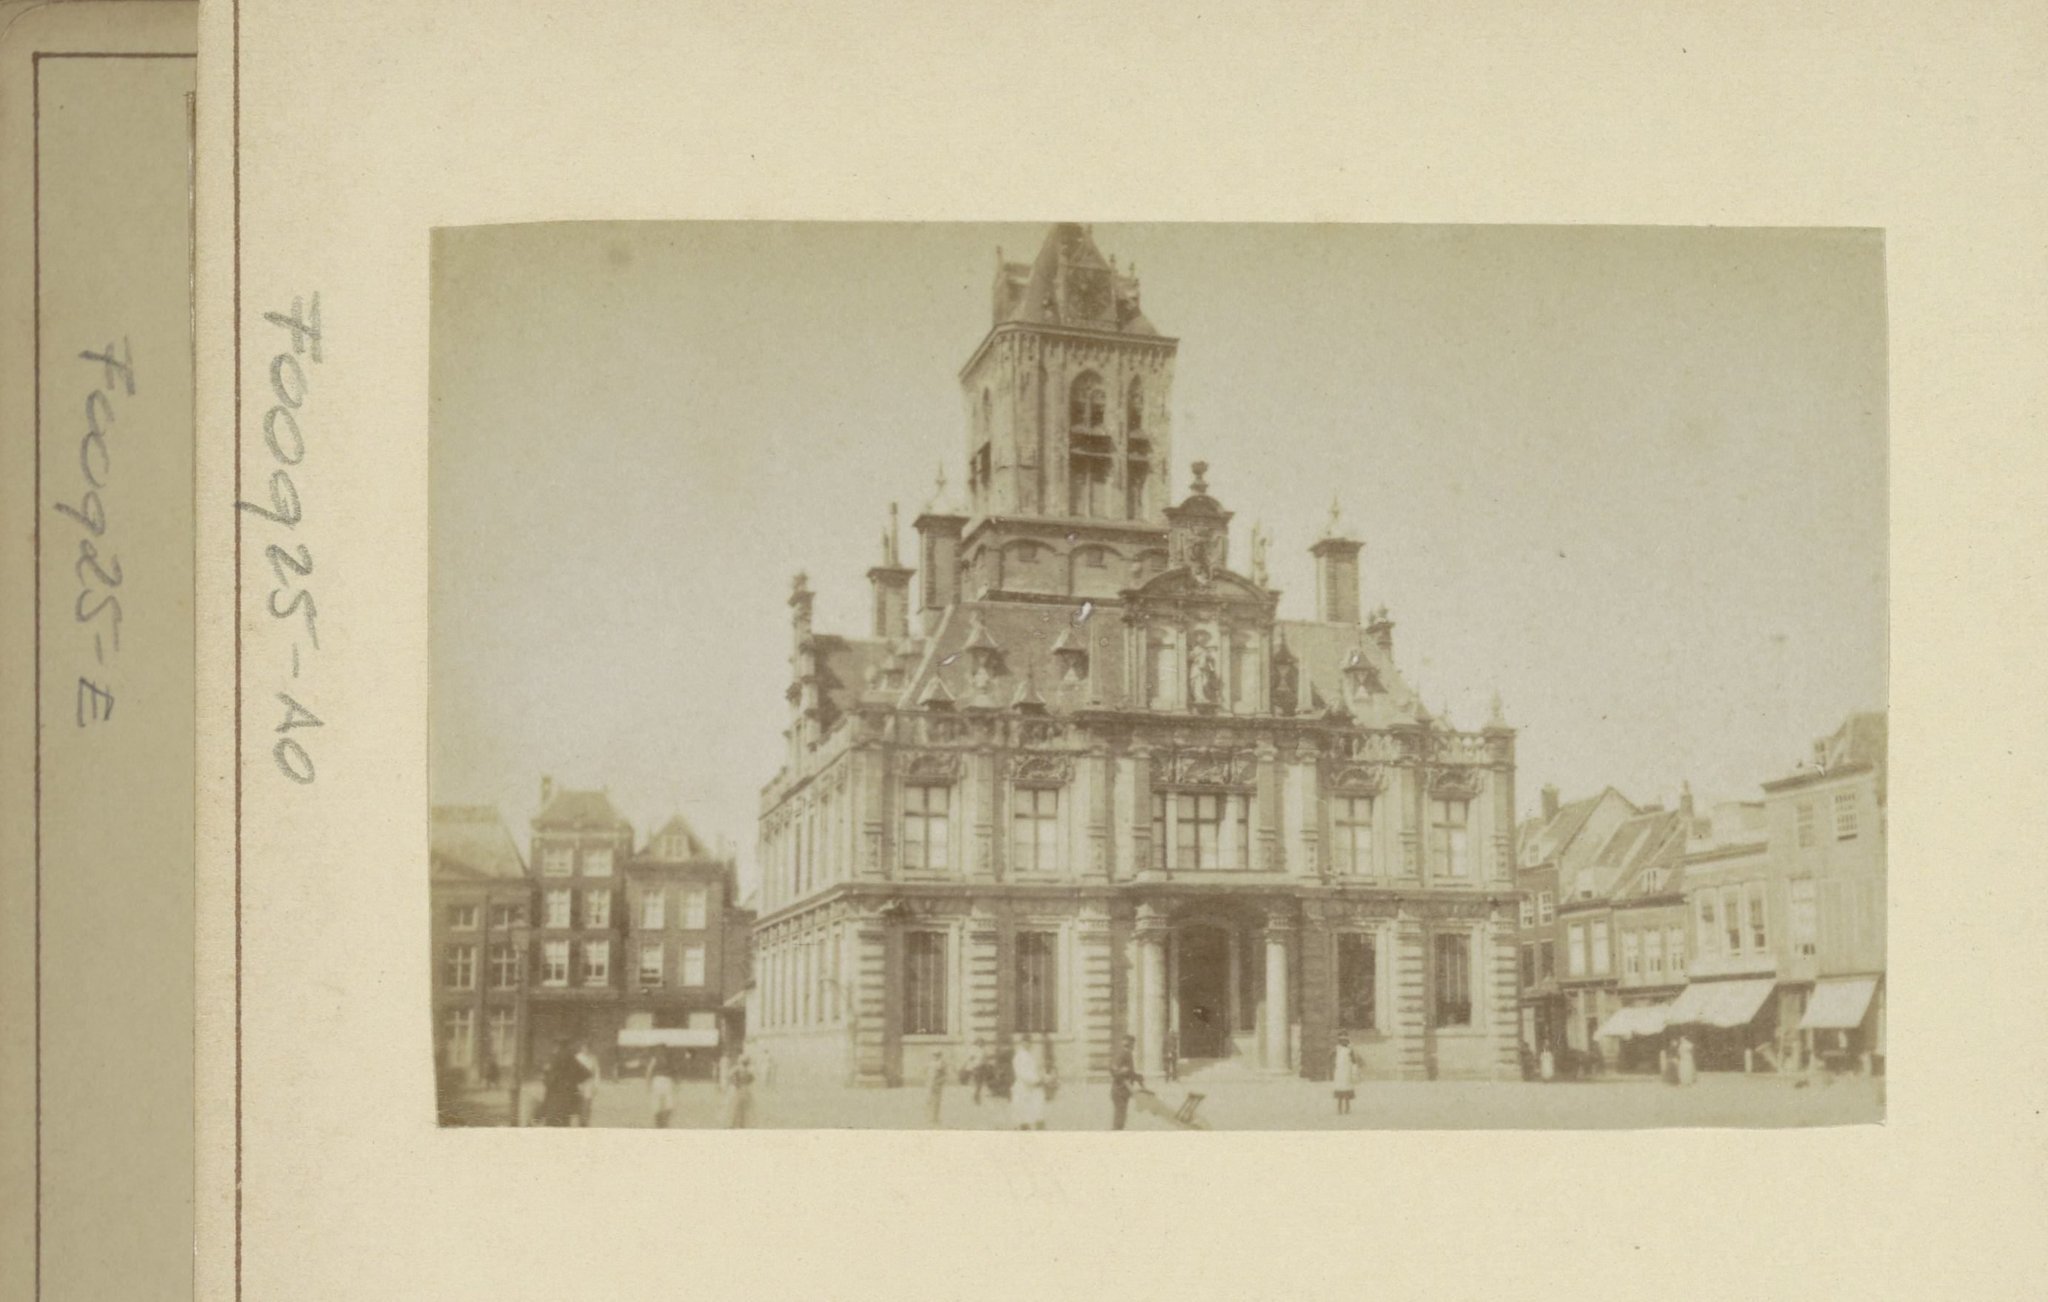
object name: album leaf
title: Delft. Het Stadhuis.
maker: andries jager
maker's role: publisher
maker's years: 1825-1905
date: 1860-1900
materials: cardboard, photographic support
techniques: albumen print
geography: delft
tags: square, place, circus, etc., townhall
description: Onderdeel van Fotoalbum met opnames van steden in Noord- en Zuid-Holland en Utrecht.